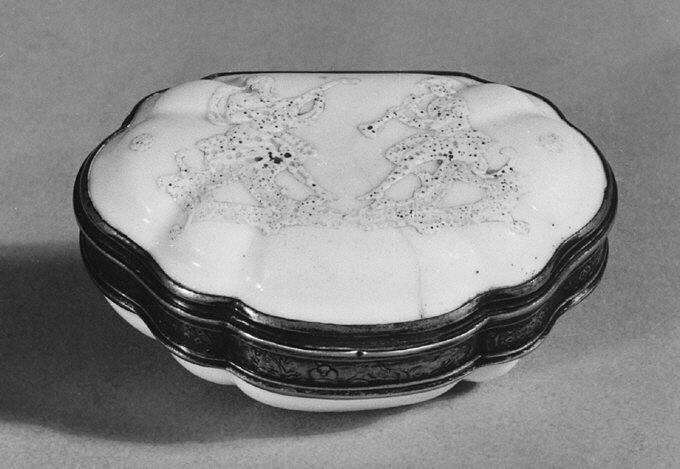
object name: snuffbox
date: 1740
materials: soft paste porcelain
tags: human figures